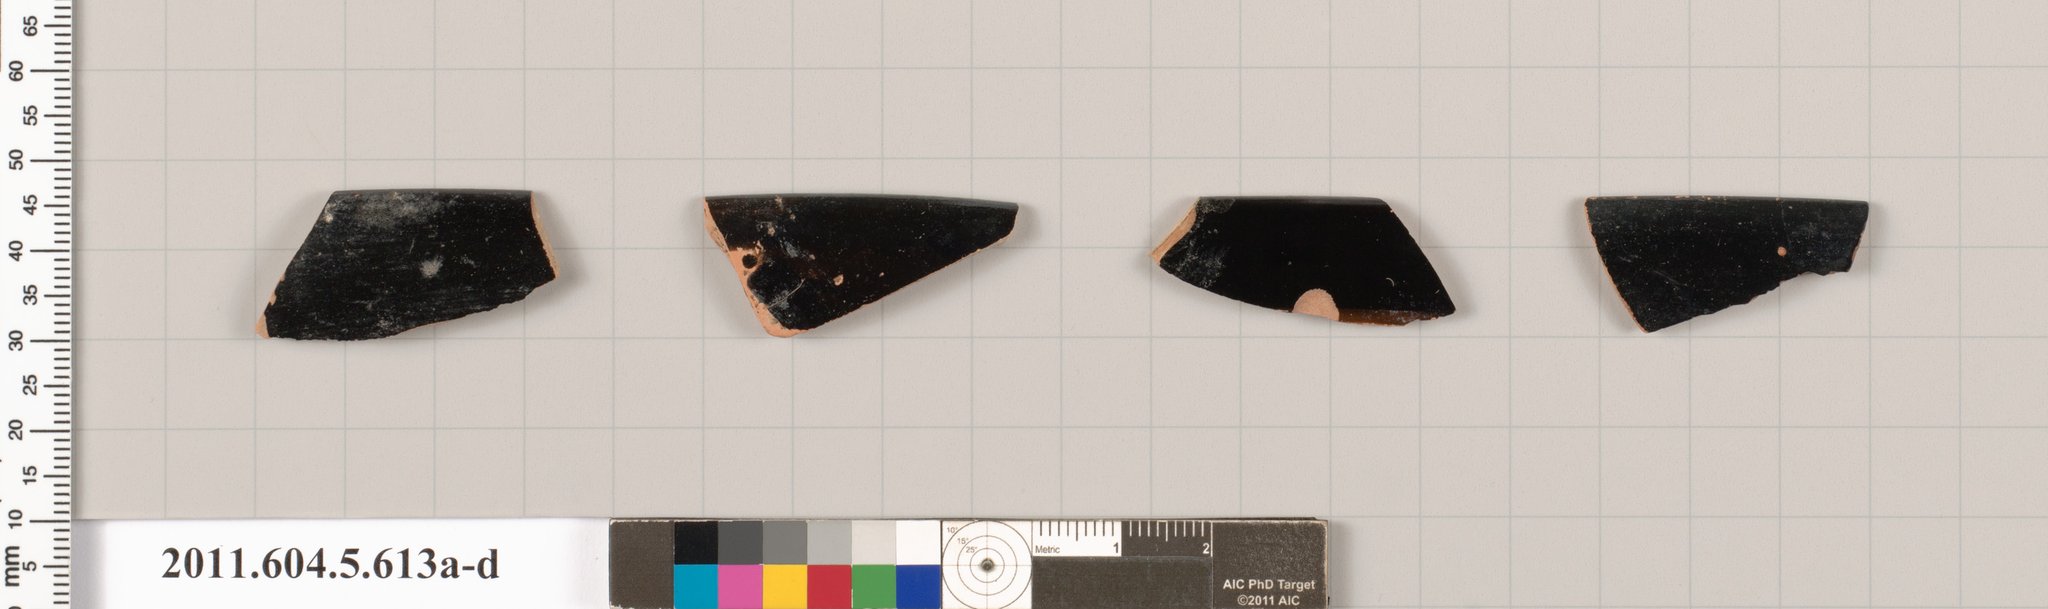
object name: kylix fragment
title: Terracotta rim fragments of kylikes (drinking cups)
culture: greek, attic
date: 600-401 BCE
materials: terracotta